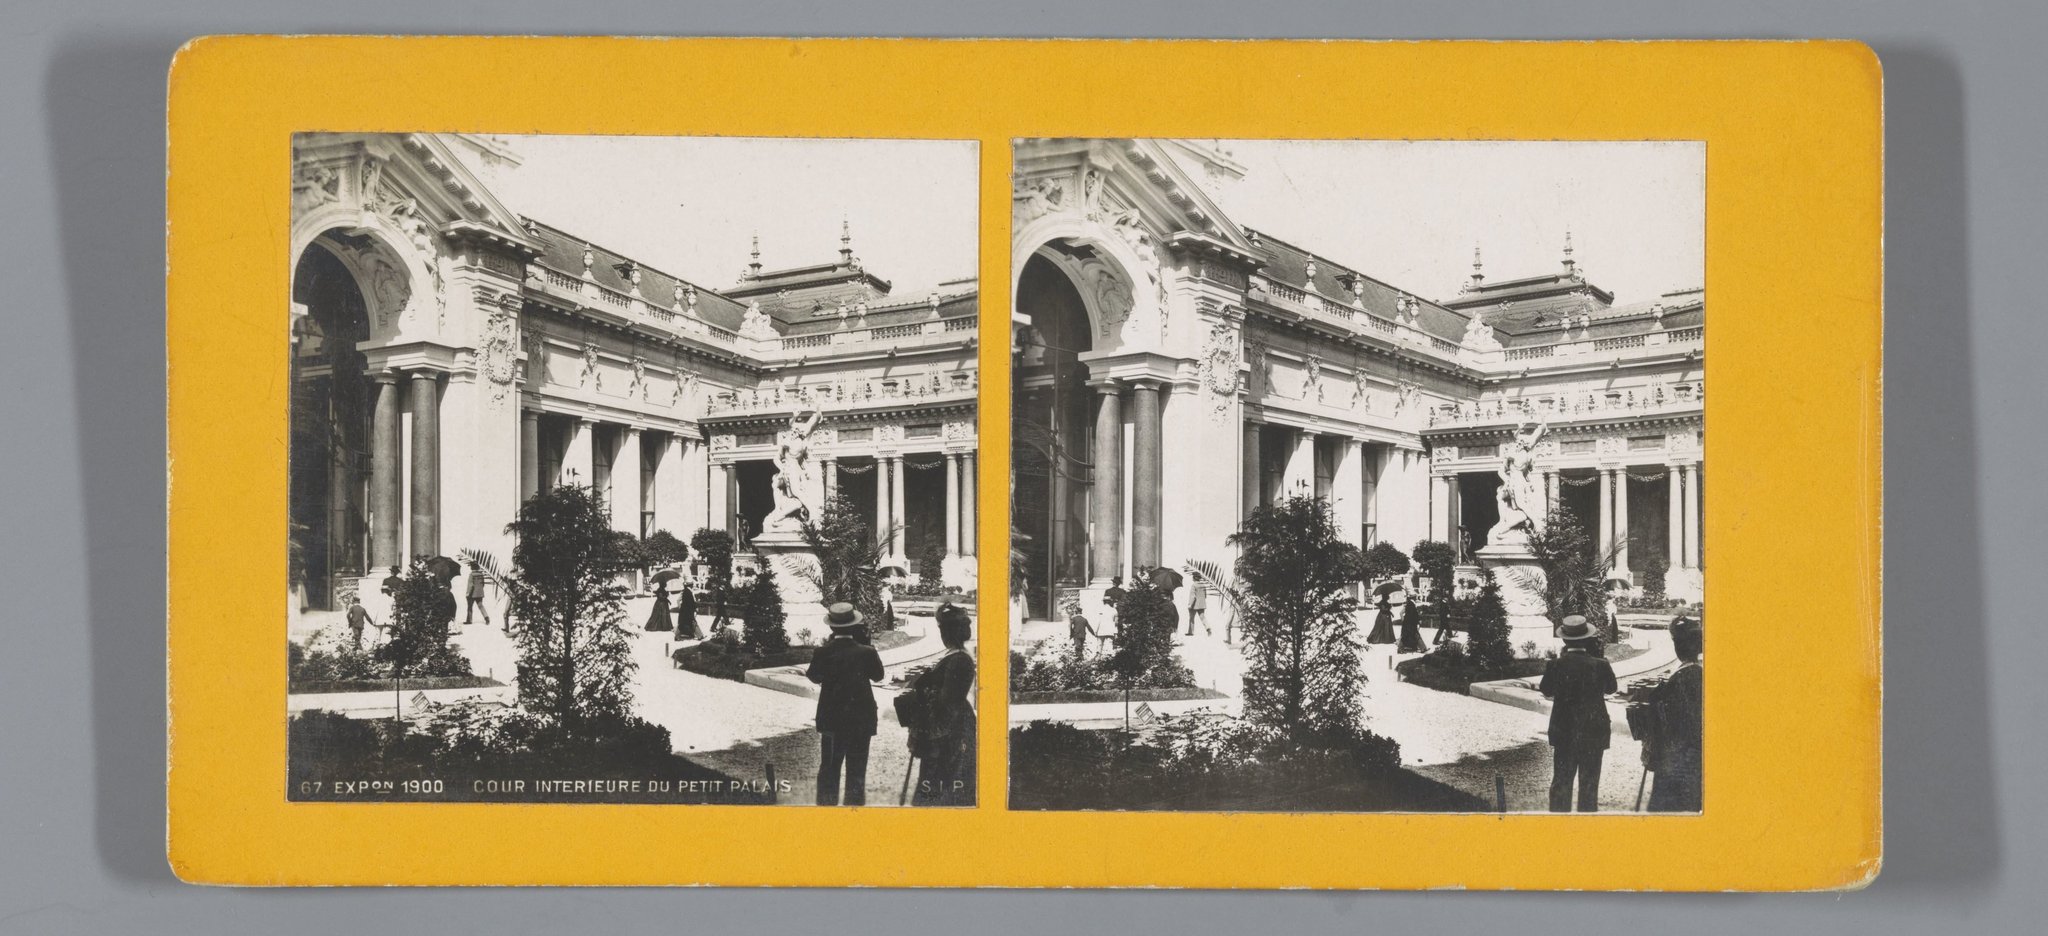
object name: stereograph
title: Expon 1900 Cour interieur du Petit Palais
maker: Anonymous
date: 1900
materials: paper, cardboard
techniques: gelatin silver print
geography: rueil-malmaison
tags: world fair, world exhibition, inner court of palace or 'hôtel'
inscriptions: number: ‘67’